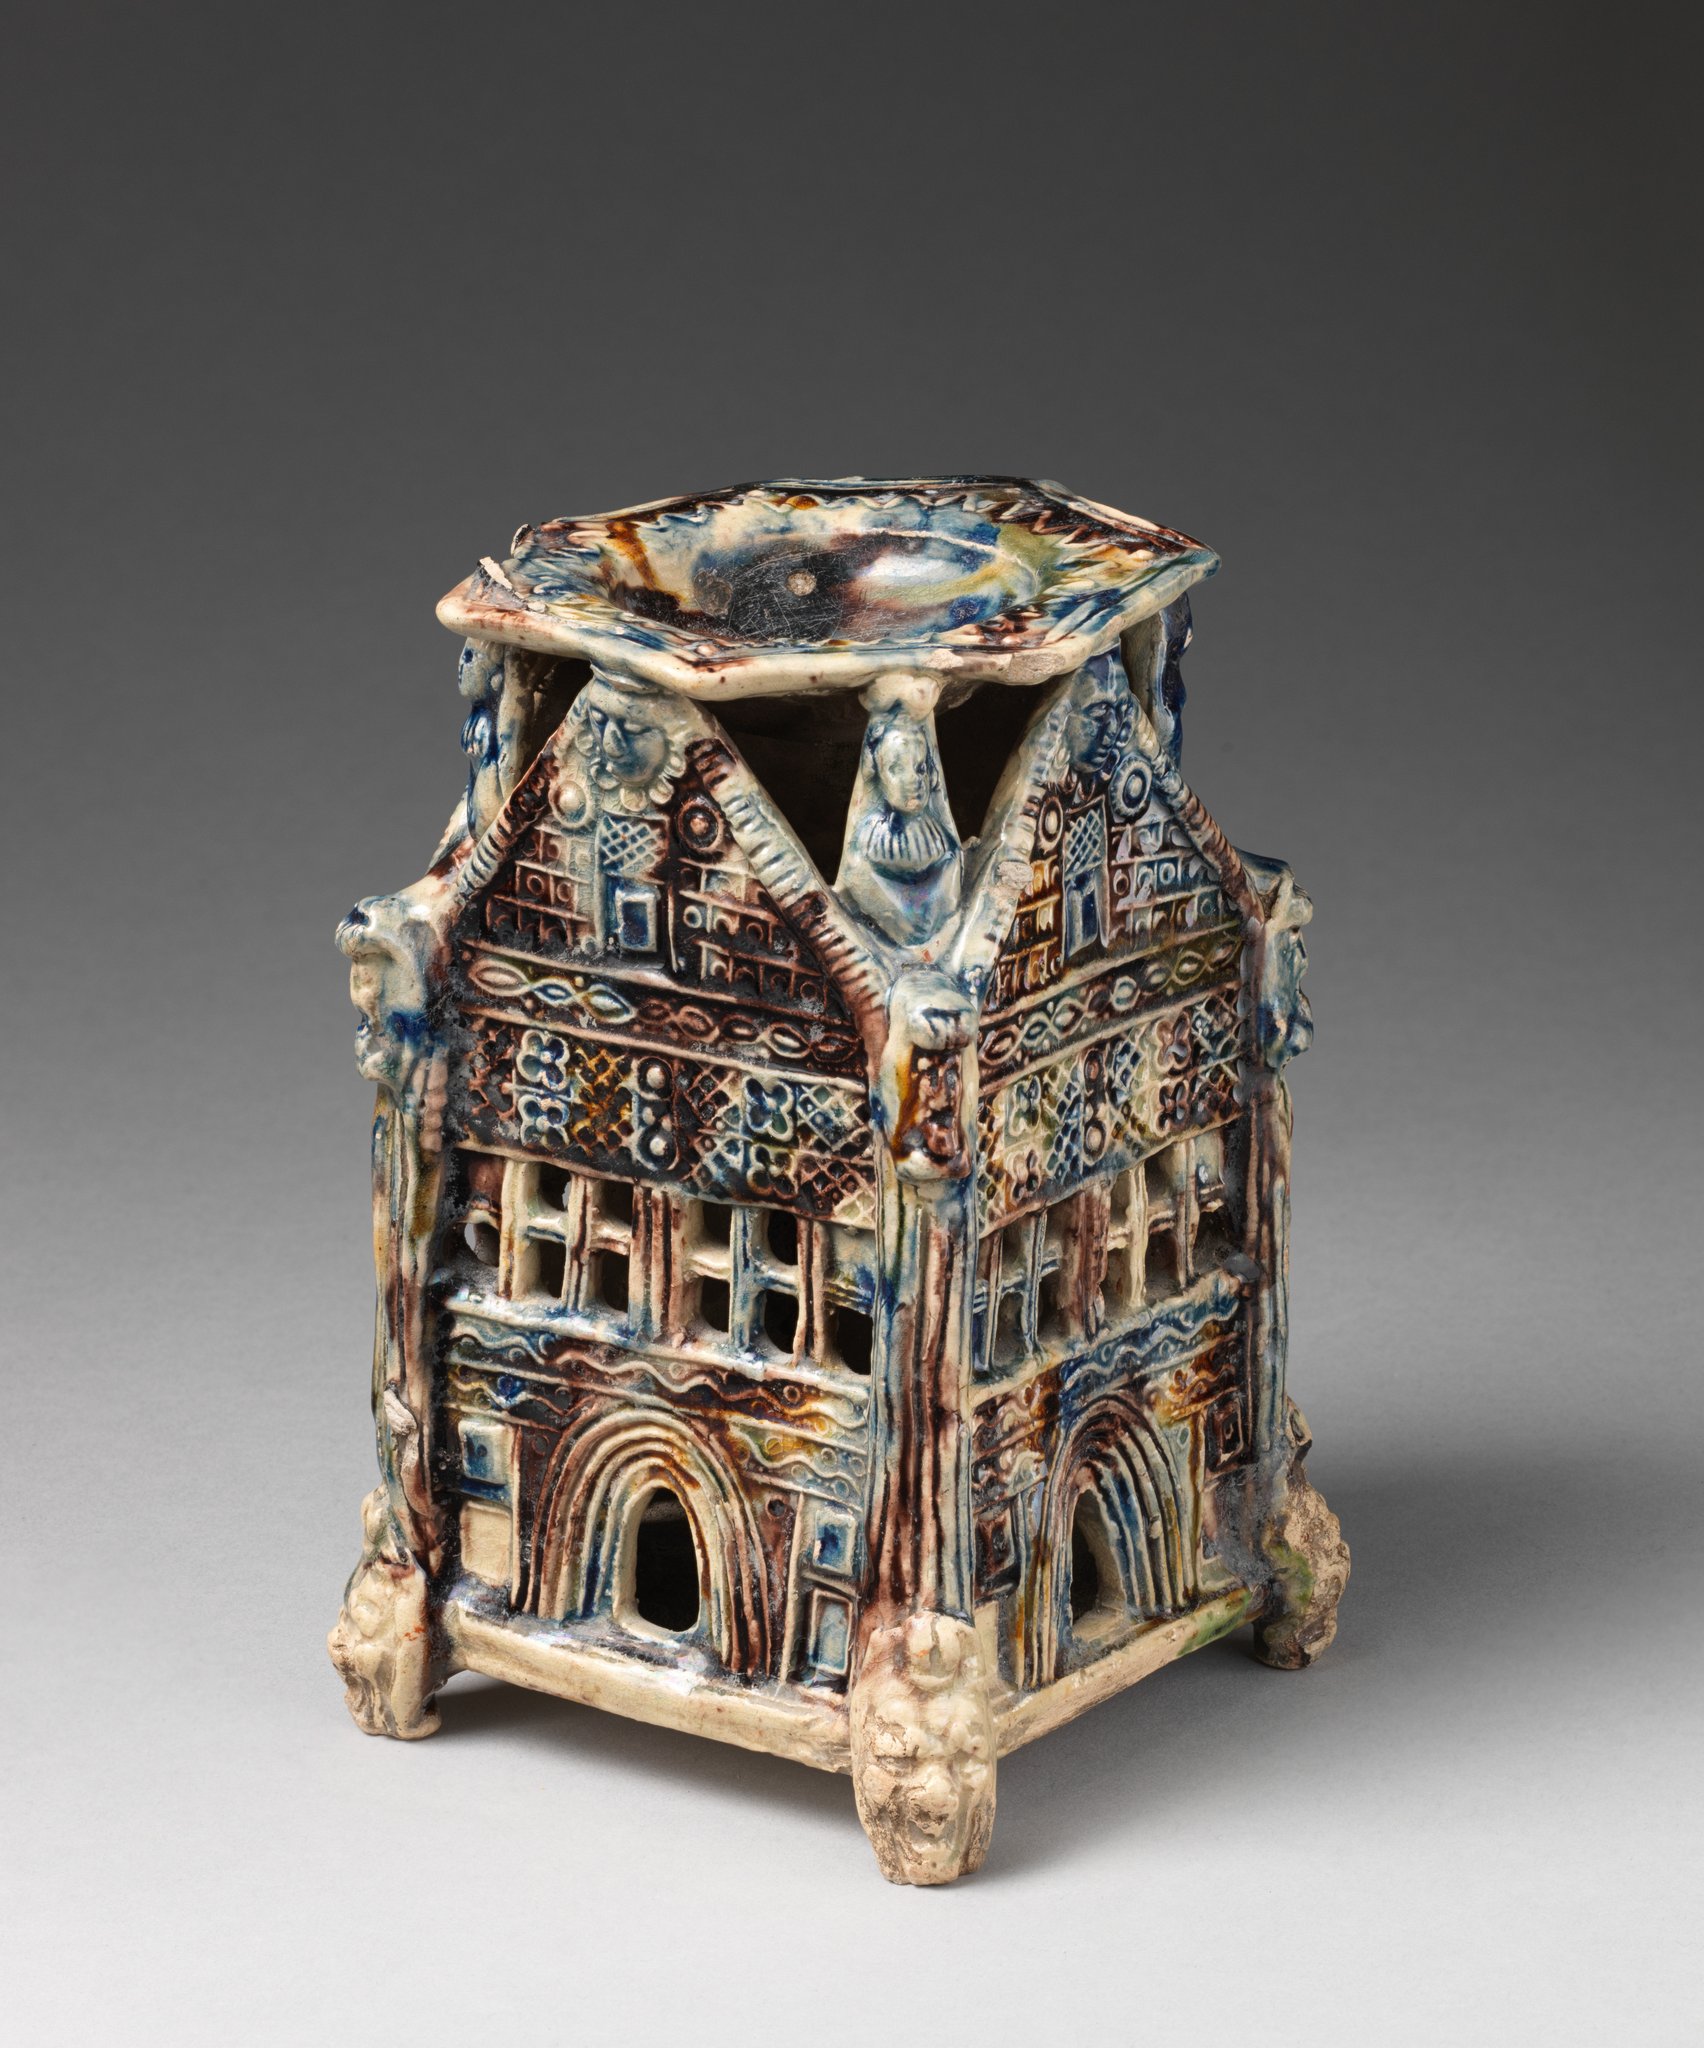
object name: salt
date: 1501-1600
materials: earthenware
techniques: glazing